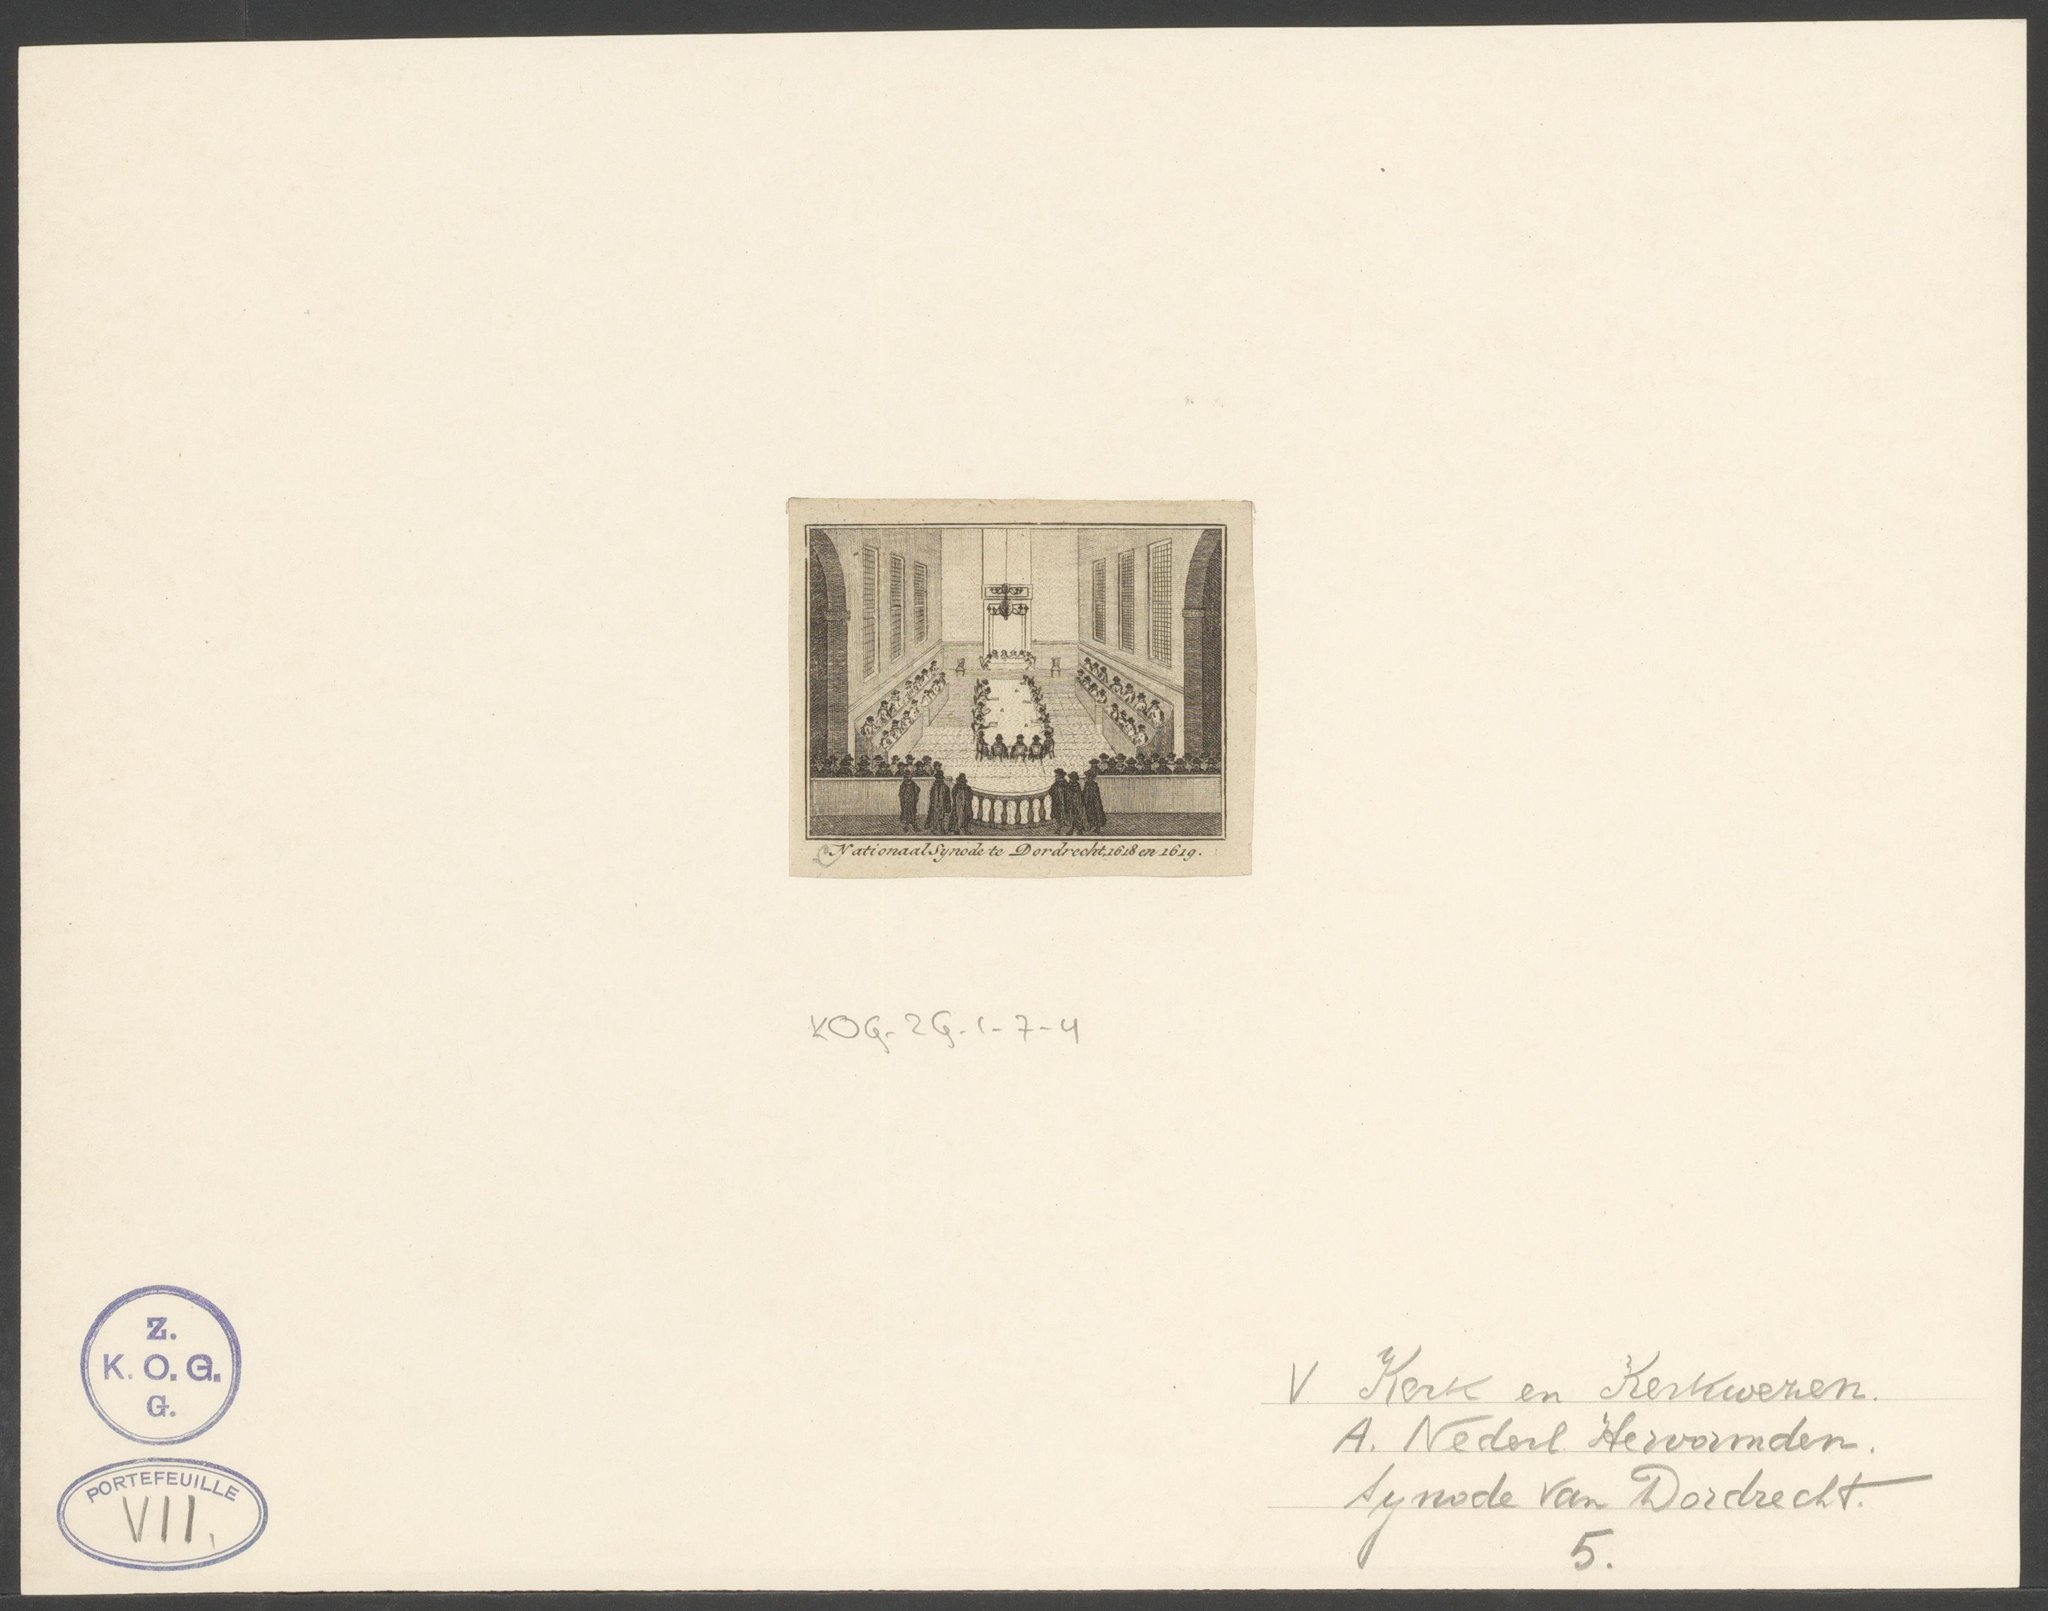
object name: print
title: Synode van Dordrecht, 1618-1619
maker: Anonymous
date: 1619-1699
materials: paper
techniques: etching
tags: organizations, assemblies, etc. in protestant churches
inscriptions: stamp, collector's mark: Lugt 1641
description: Gezicht in de grote zaal van de Kloveniersdoelen met alle aanwezigen en toeschouwers tijdens de Synode van Dordrecht. Onderwerpsrubrieken binnen de Atlas Zeden en Gewoonten: Godsdienst, Ned. Hervormden, (Oudtijds Gereformeerden), Synode van Dordrecht.